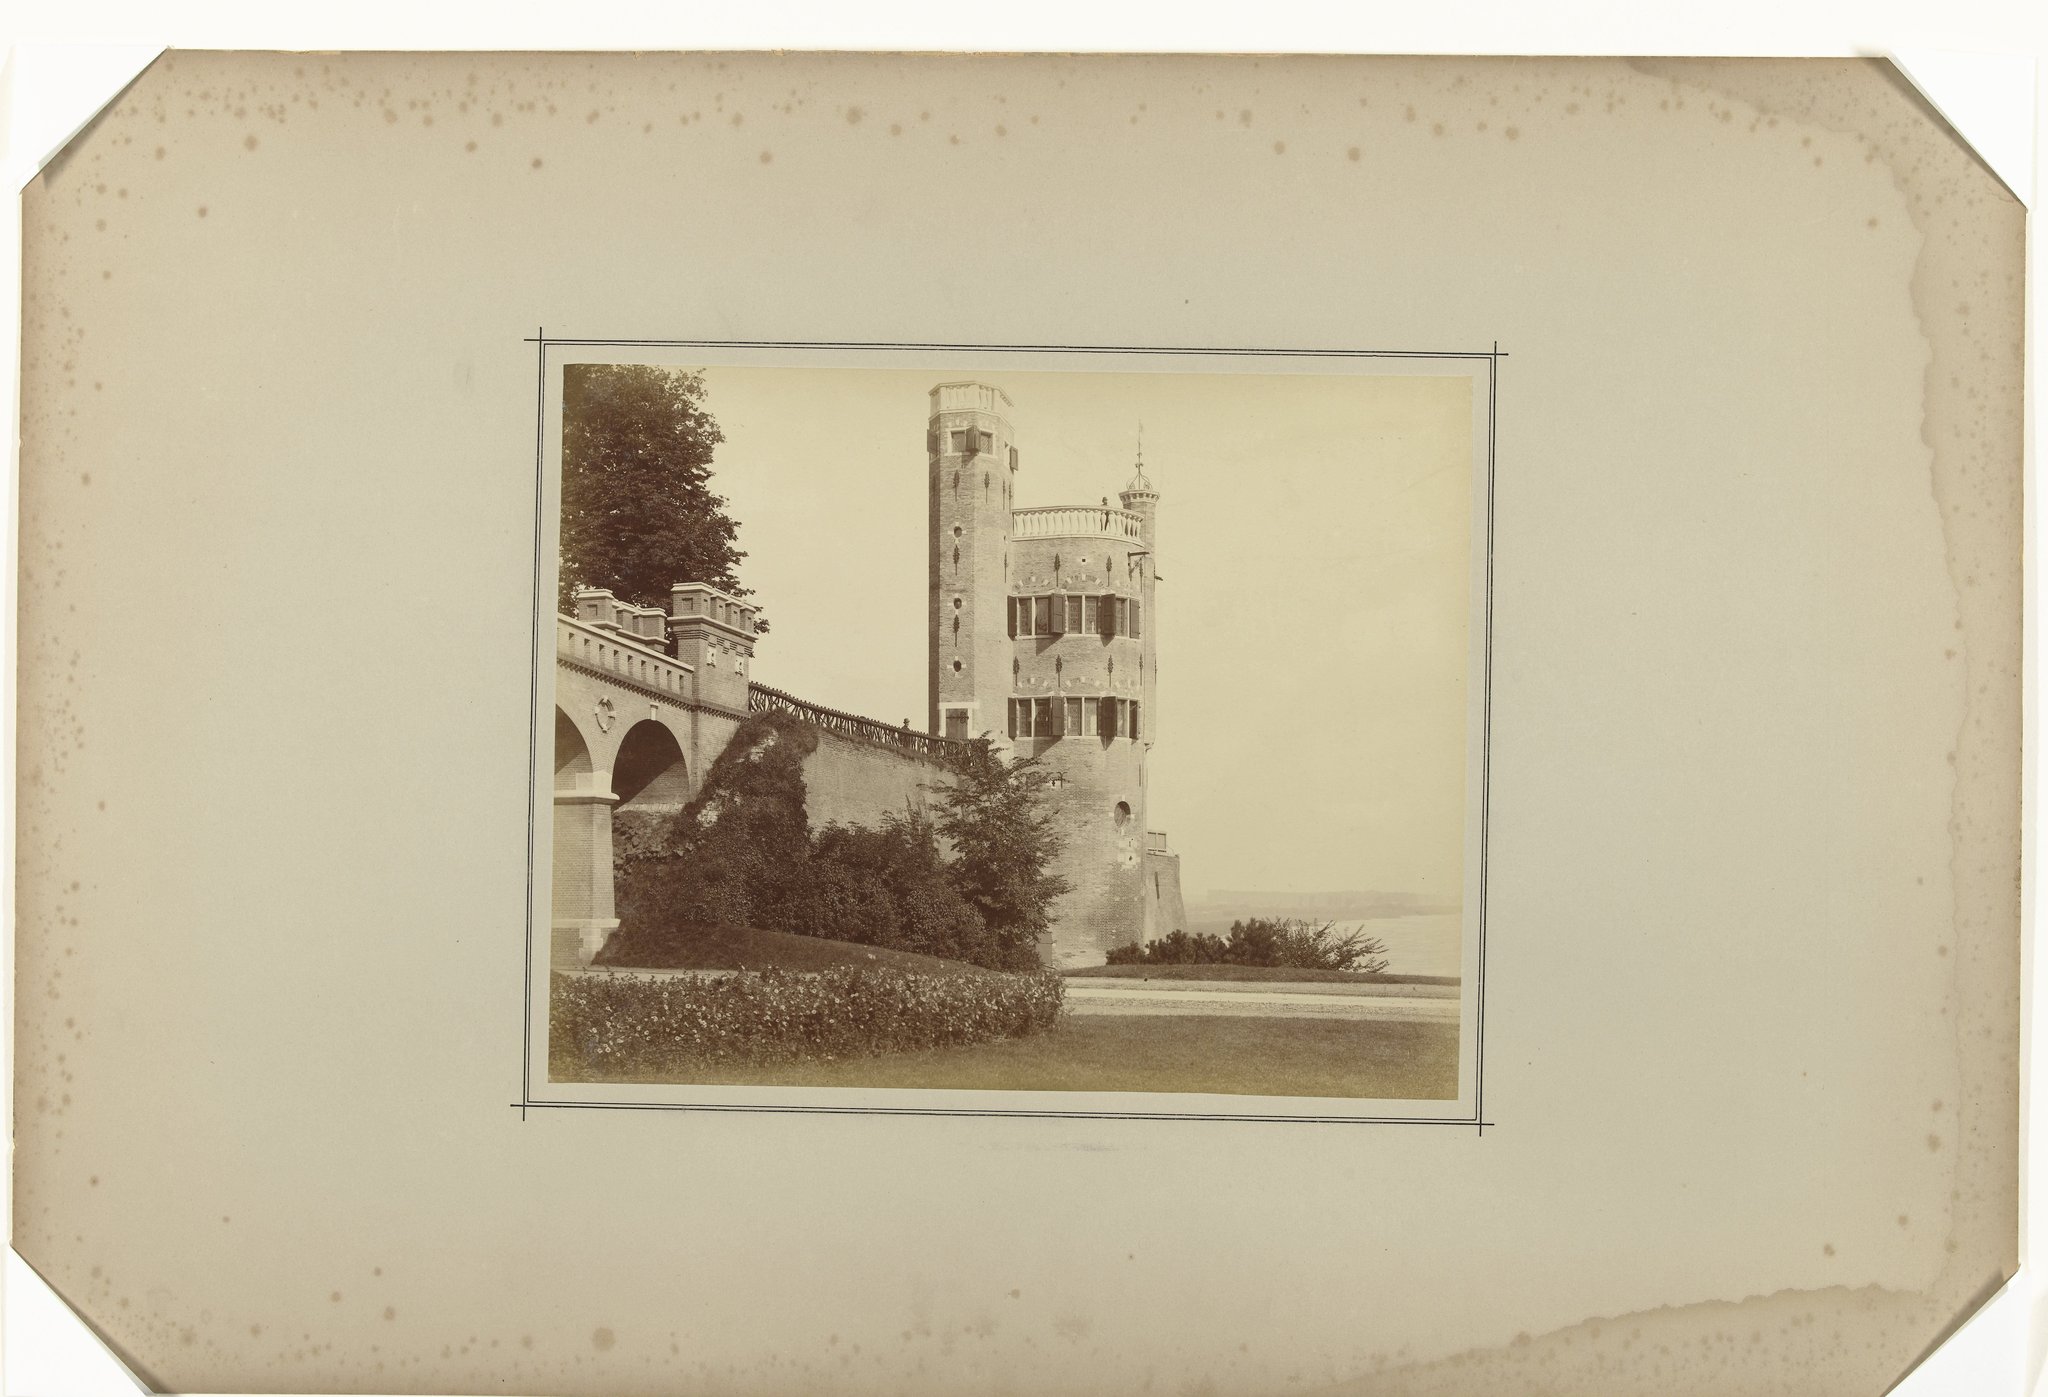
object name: photograph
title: Belvédère in Nijmegen, met de architect en amateur-archeoloog J.J. Weve op het eerste balkon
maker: wilhelm ivens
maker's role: fotograaf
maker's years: 1849-1904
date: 1885-1890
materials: cardboard, photographic support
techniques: albumen print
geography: nijmegen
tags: belvédère (nijmegen)